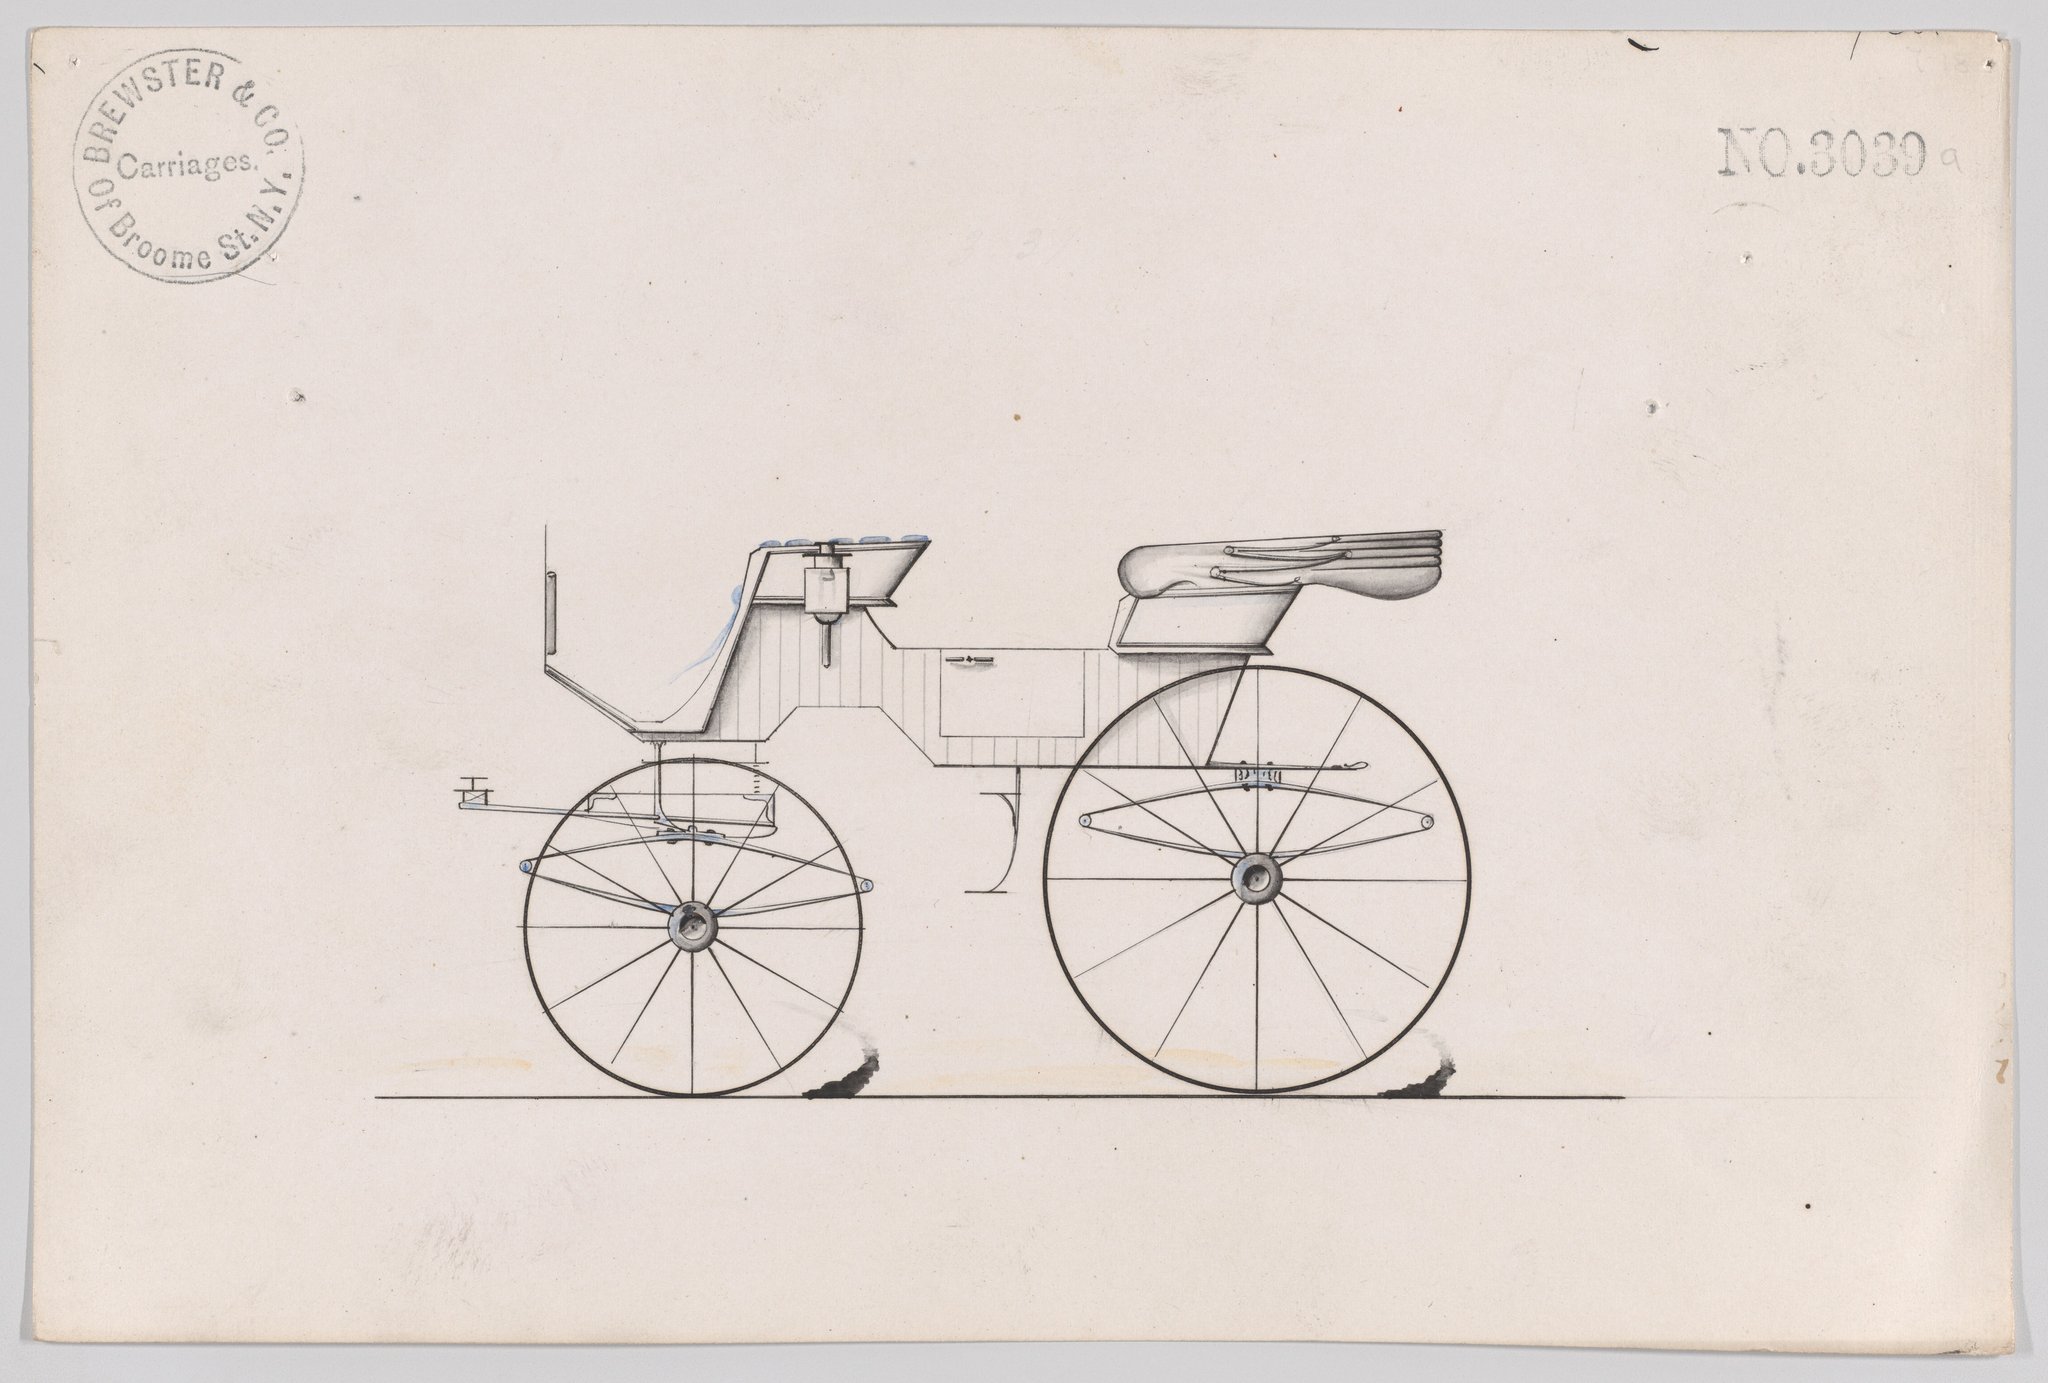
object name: drawing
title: Design for 2 seat Phaeton, no. 3039a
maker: brewster & co.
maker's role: manufacturer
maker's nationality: american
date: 1874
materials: gouache, ink, watercolor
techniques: pen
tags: carriages